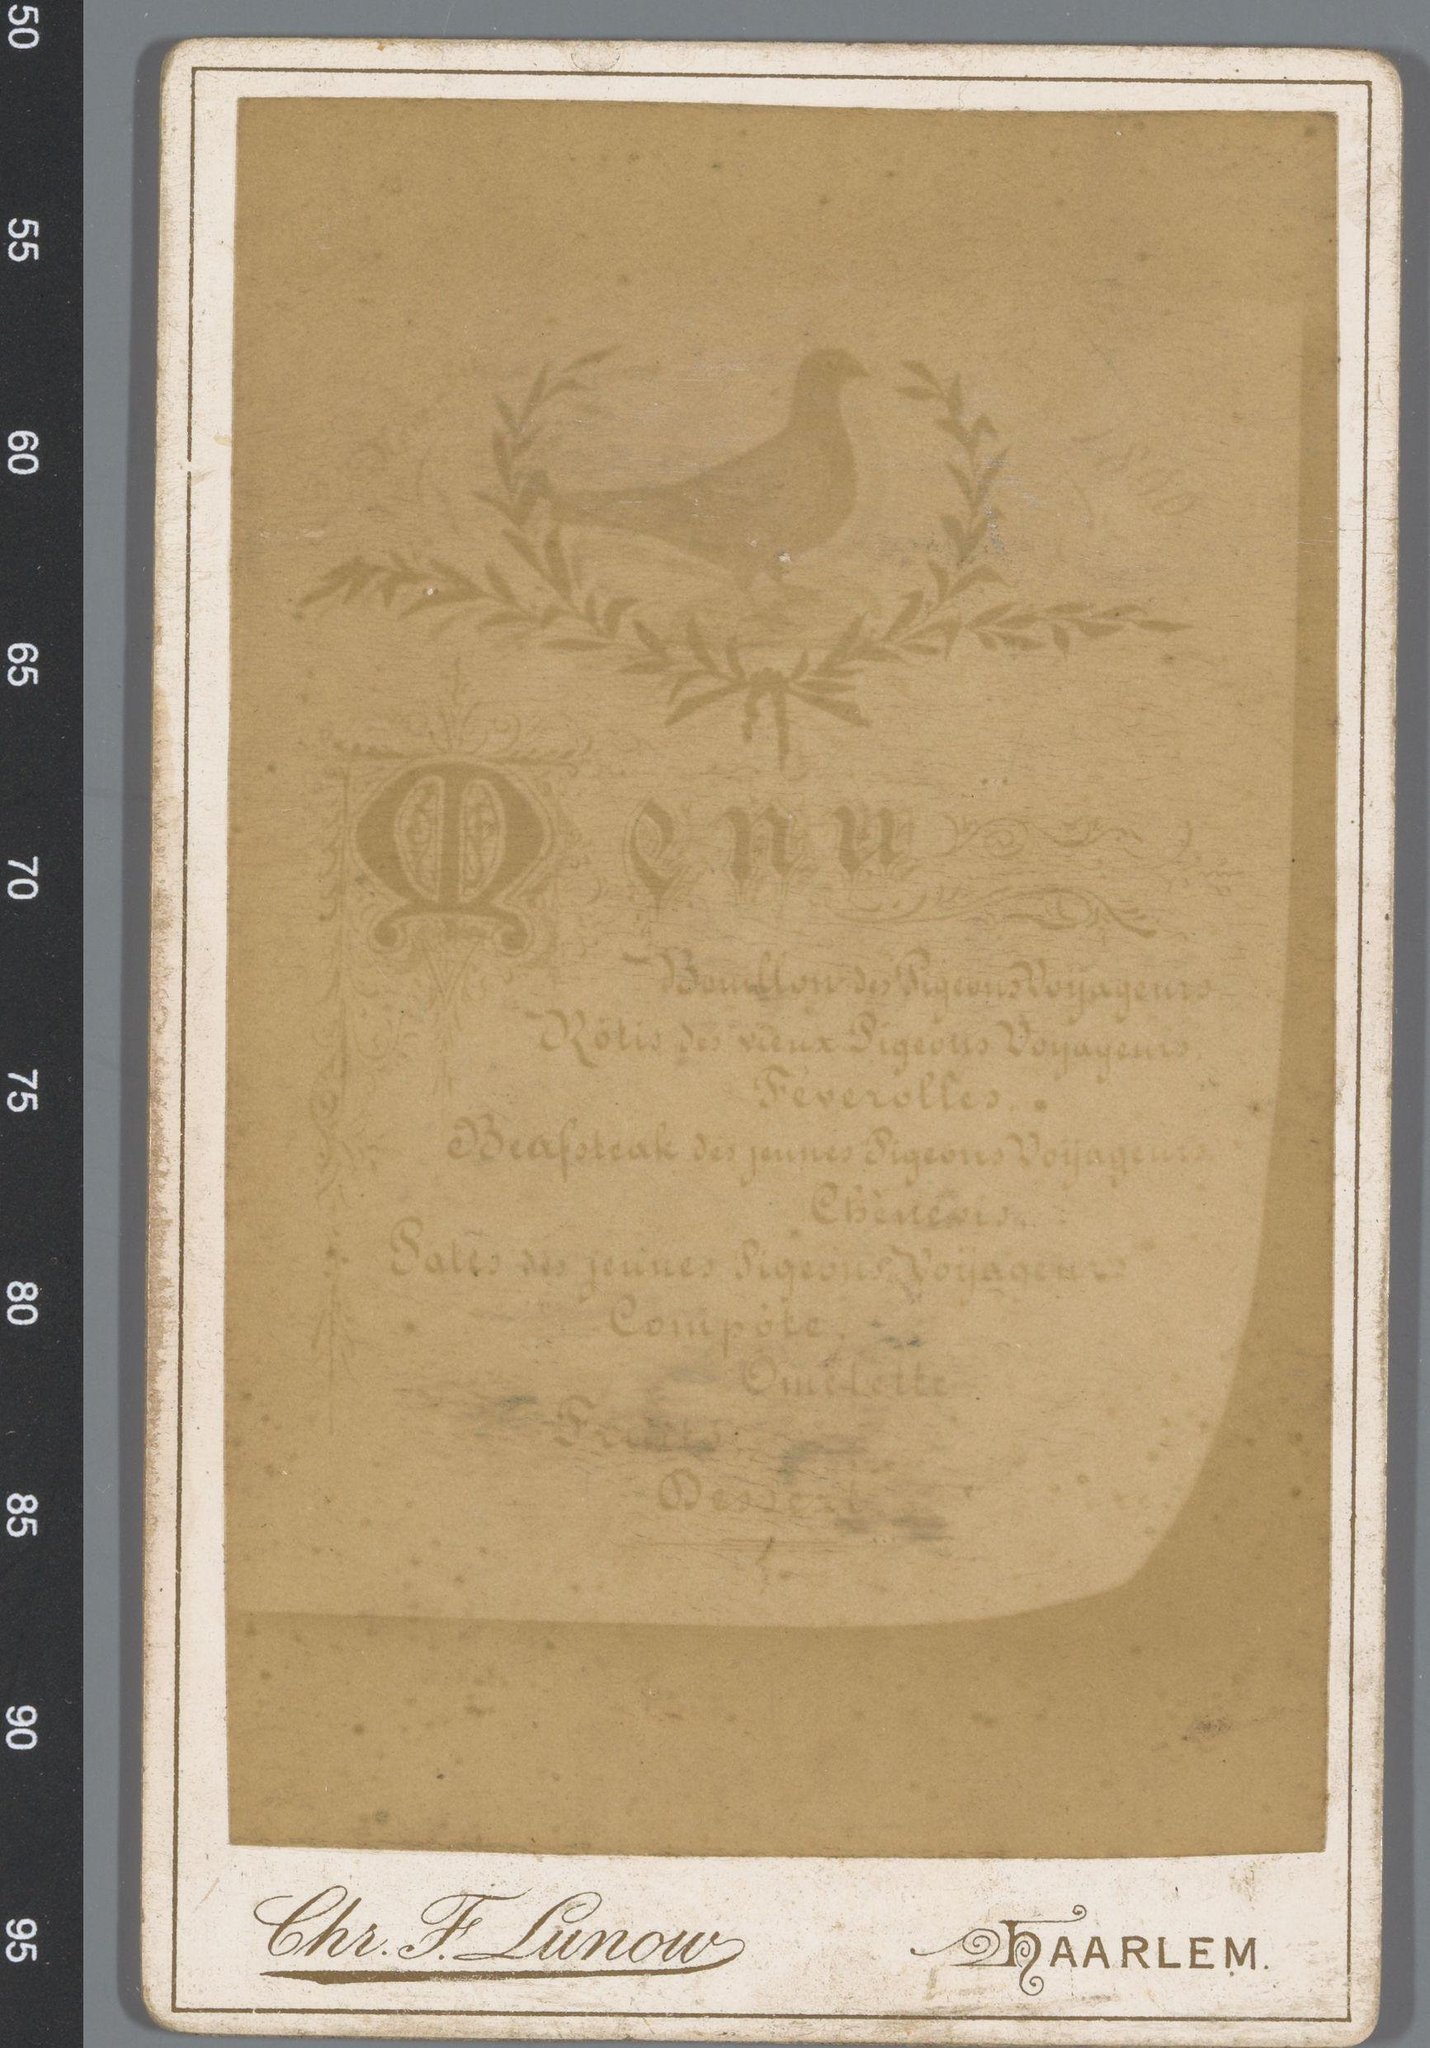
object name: carte de visite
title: Fotoreproductie van een menukaart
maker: fredrich christiaan lünow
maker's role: fotograaf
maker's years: 1857-1925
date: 1888-1899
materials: paper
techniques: albumen print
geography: haarlem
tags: doves, pigeons, haarlem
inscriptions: inscription: ‘Chr. F. Lunow Haarlem’, inscription: ‘Chr. F. Lunow/ Photograaf/ Haarlem/ Barteljorisstraat 17/ Alex Lindner - Berlin.’